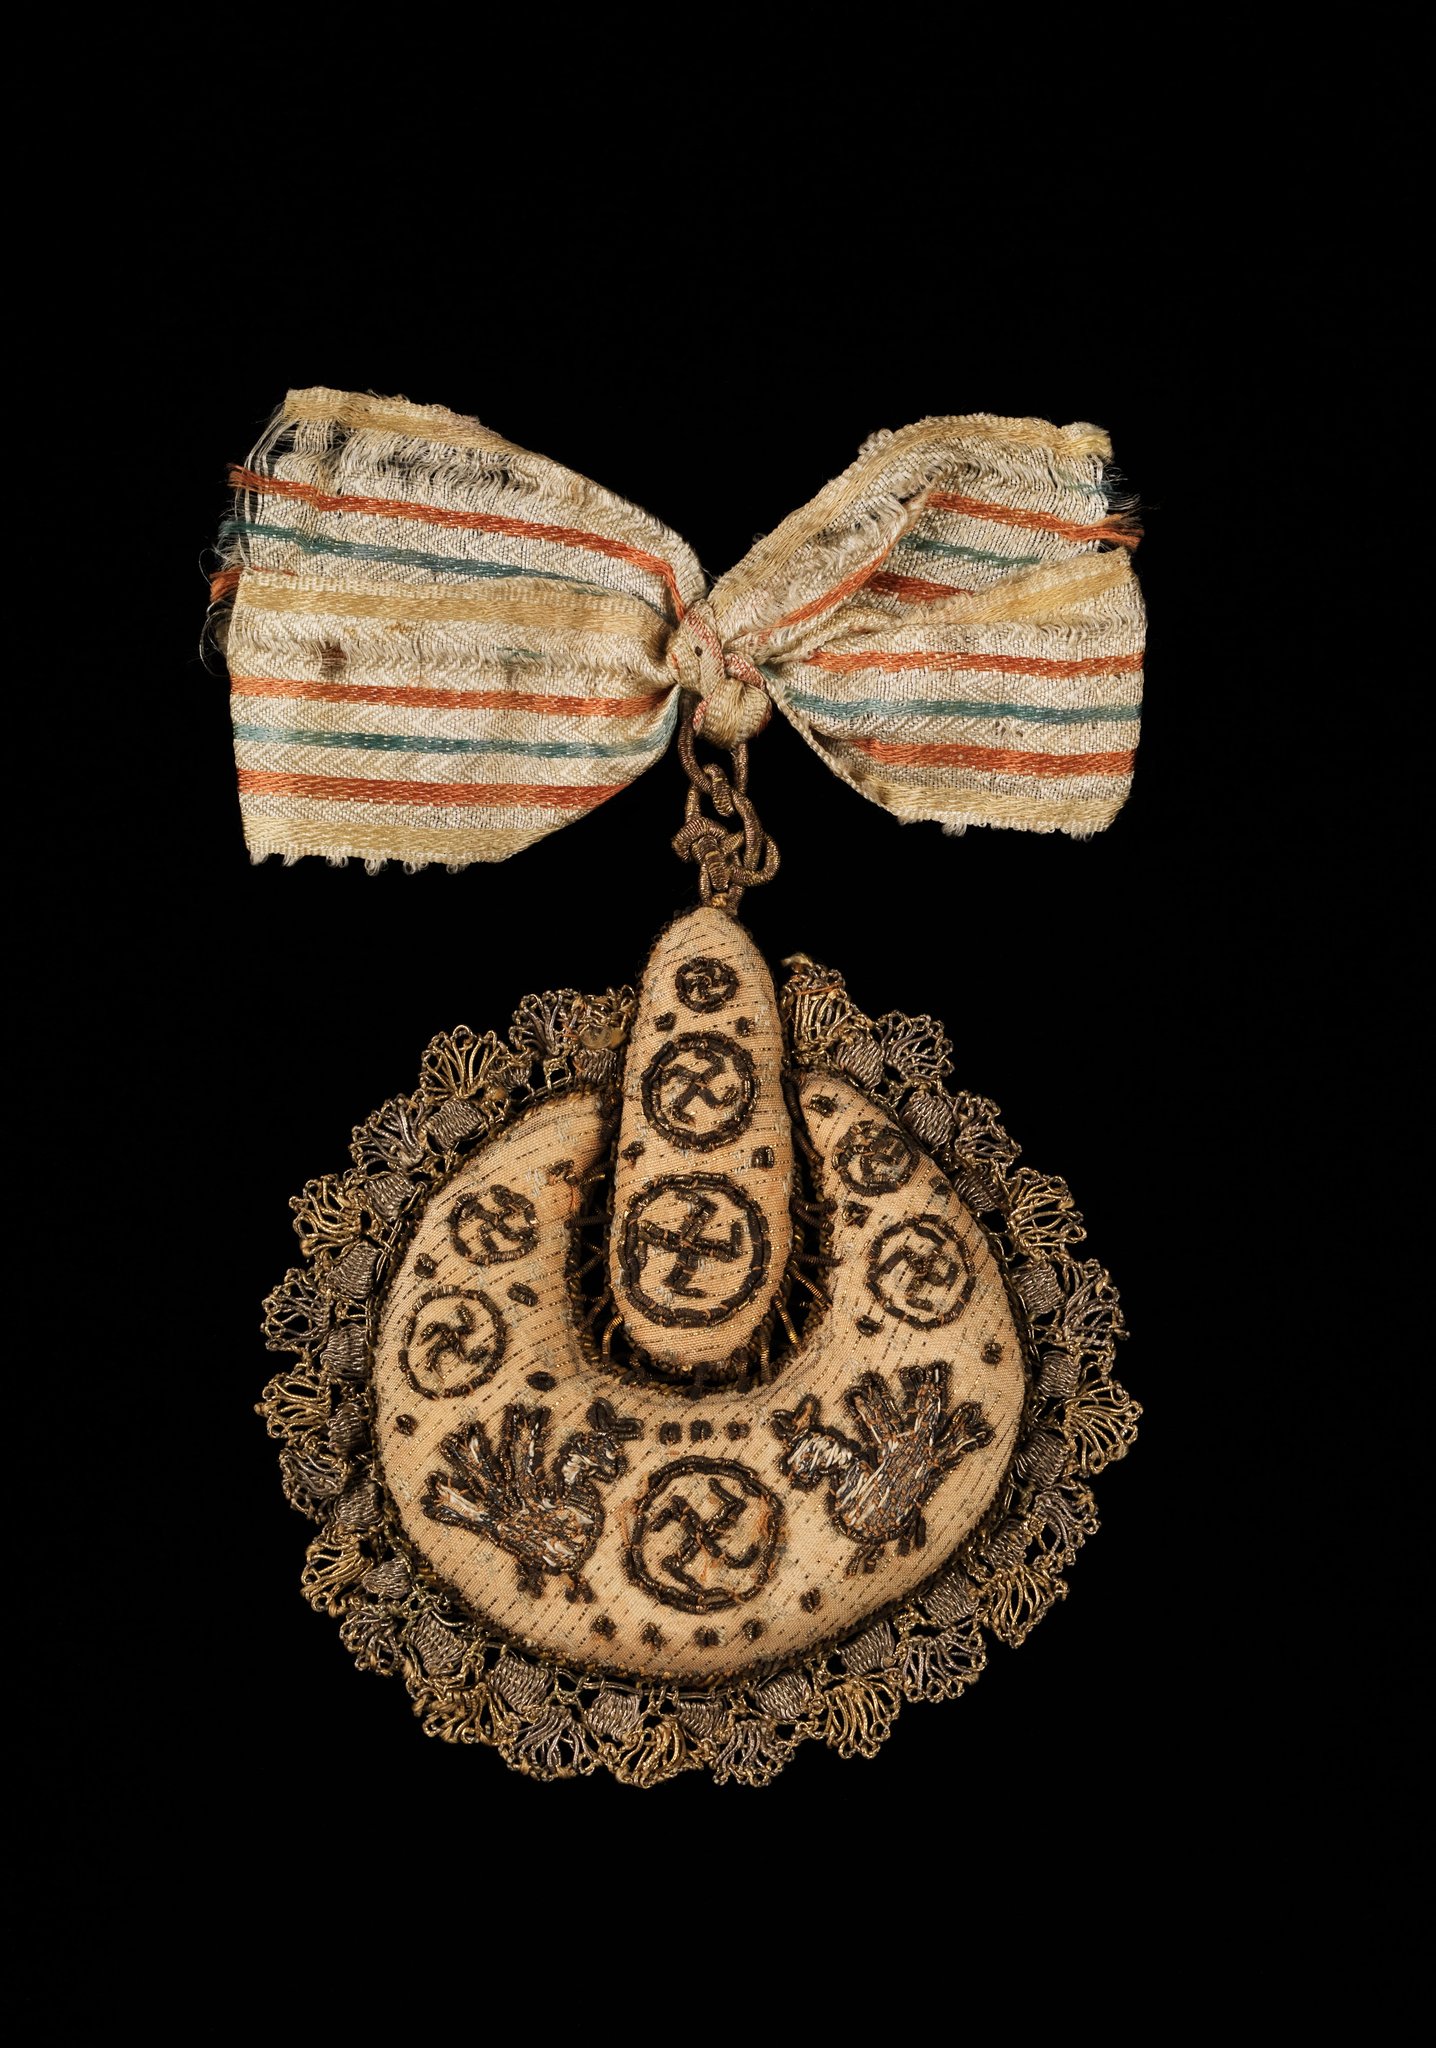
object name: hair accessory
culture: russian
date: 1830-1880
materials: metal, silk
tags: birds